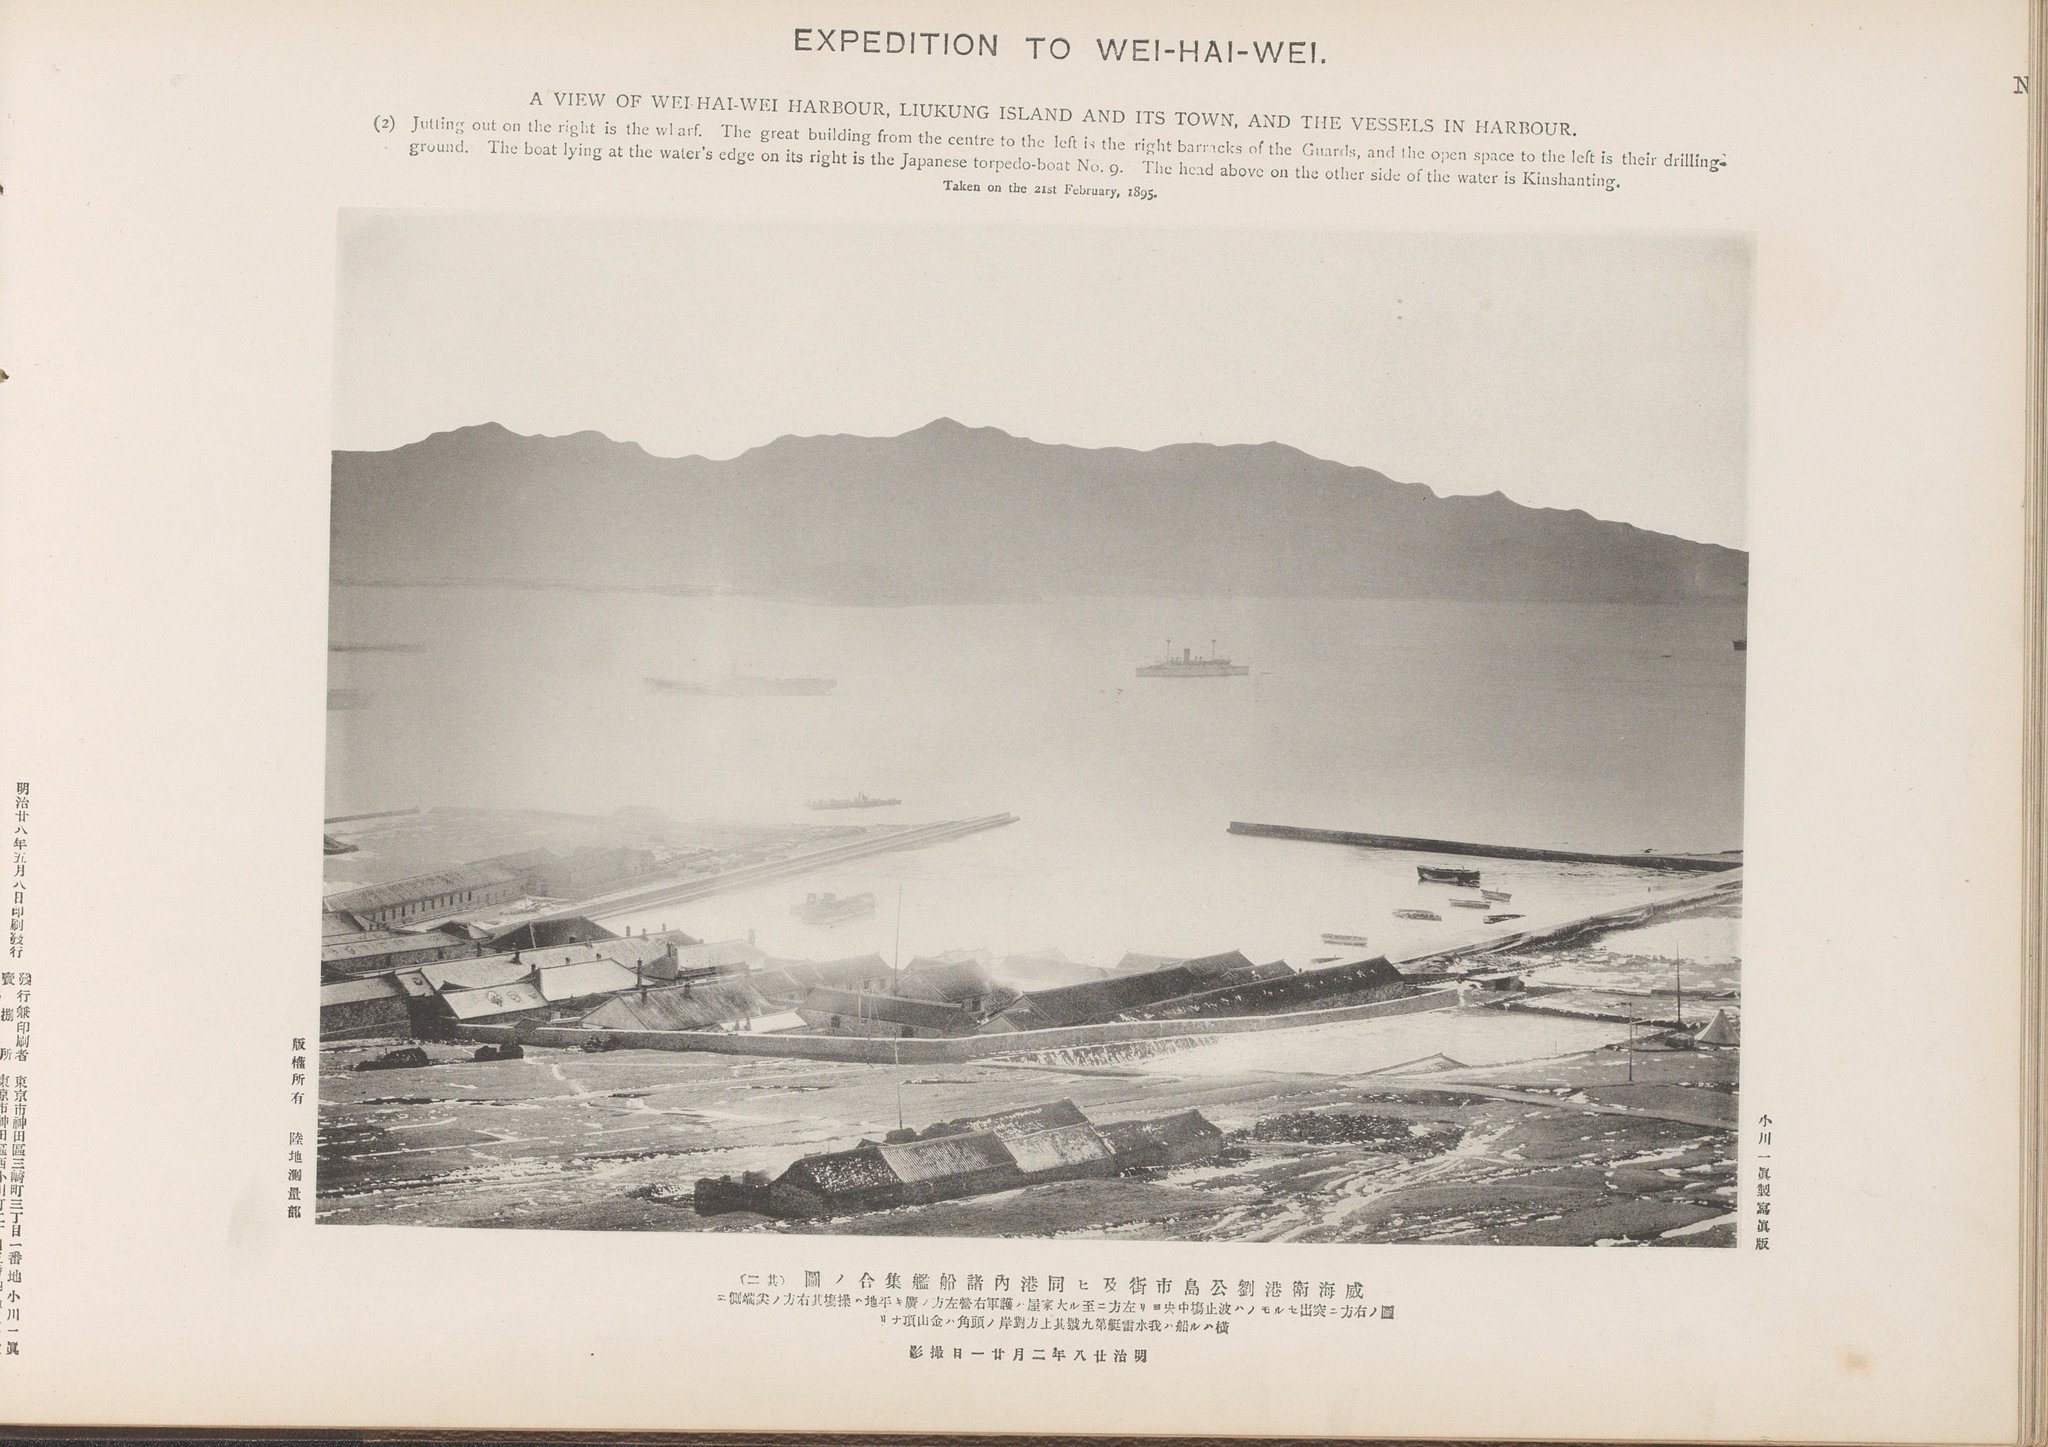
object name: photomechanical print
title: A view of Wei-Hai-Wei harbour, Liukung Island and its town, and the vessels in harbour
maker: kazumasa ogawa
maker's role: auteur, fotograaf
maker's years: 1860-1929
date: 1895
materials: paper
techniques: photograph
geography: japan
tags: harbour, ships (in general)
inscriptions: inscription: ‘Expedition to Wei-Hai-Wei.’, inscription: ‘Jutting out on the right (...) The head above on the other side of the water is Kinshanting.’